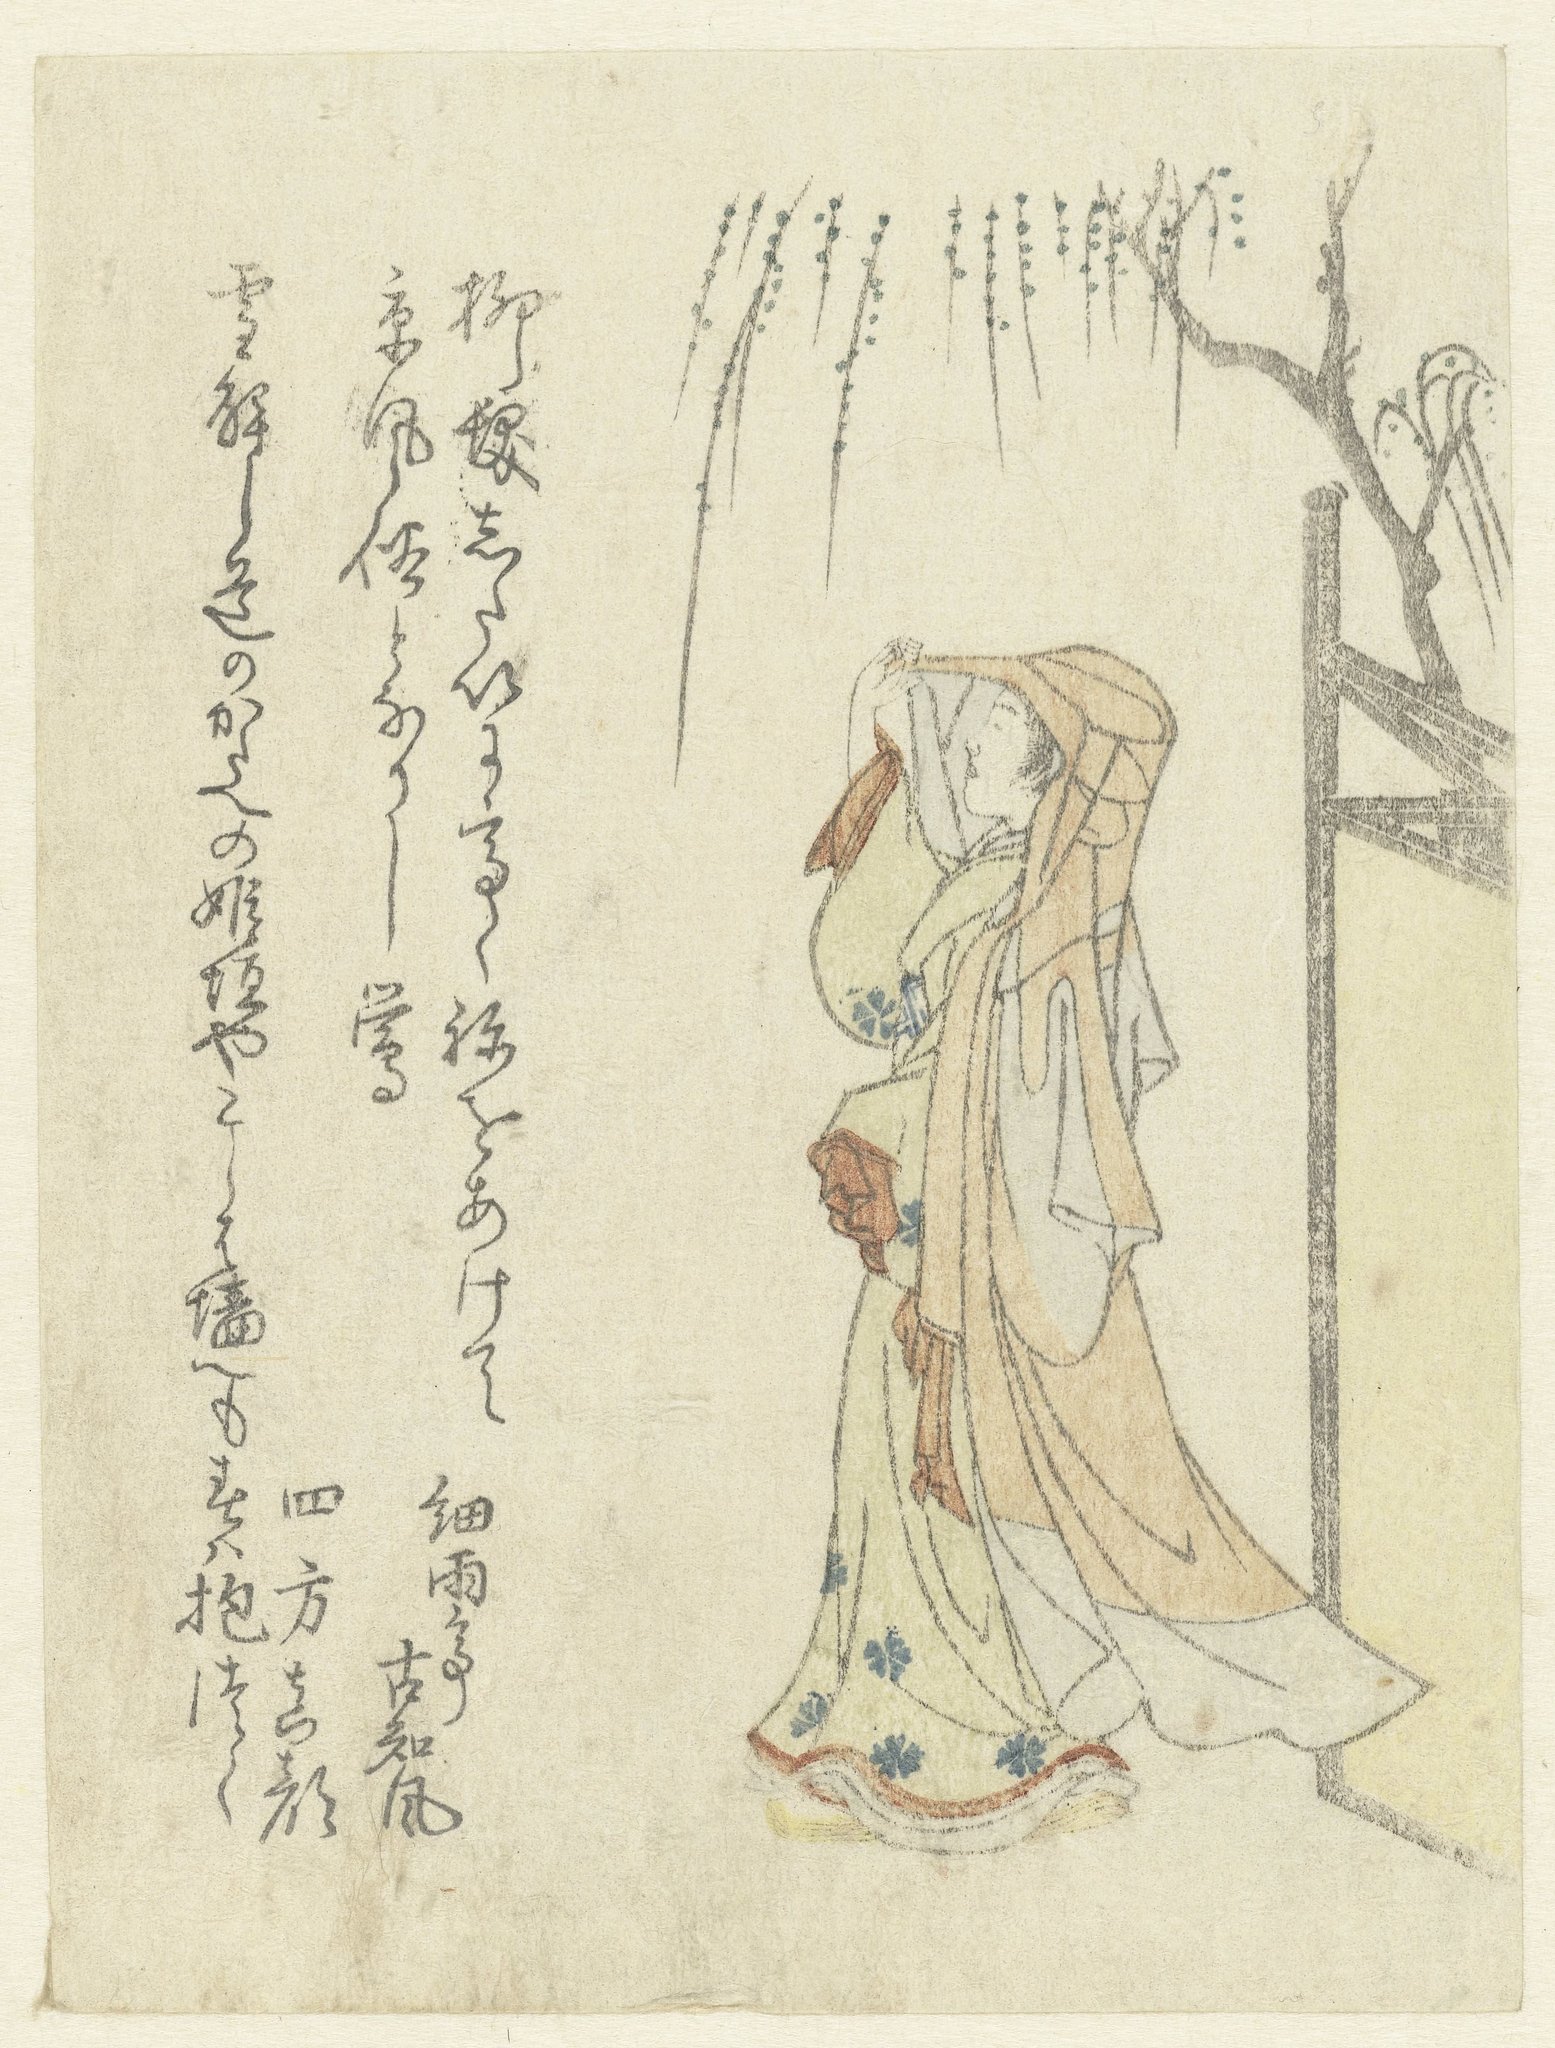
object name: surimono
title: A Court Lady under a Willow Tree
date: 1790-1800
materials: paper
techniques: blind stamped, woodcut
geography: japan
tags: trees, standing figure - aa - female human figure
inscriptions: collector's mark, verso, stamped: Lugt 2973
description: Een surimono is een luxe uitgevoerde prent waarop beeld met één of meerdere gedichten gecombineerd is. Bij het drukken van een surimono werd vaak gebruik gemaakt van dikker papier, blinddruk en metaal pigmenten, zoals koper- en zilverpoeder. De prenten werden vaak in opdracht van dichters gemaakt en als exclusief geschenk aan vrienden en relaties gegeven.